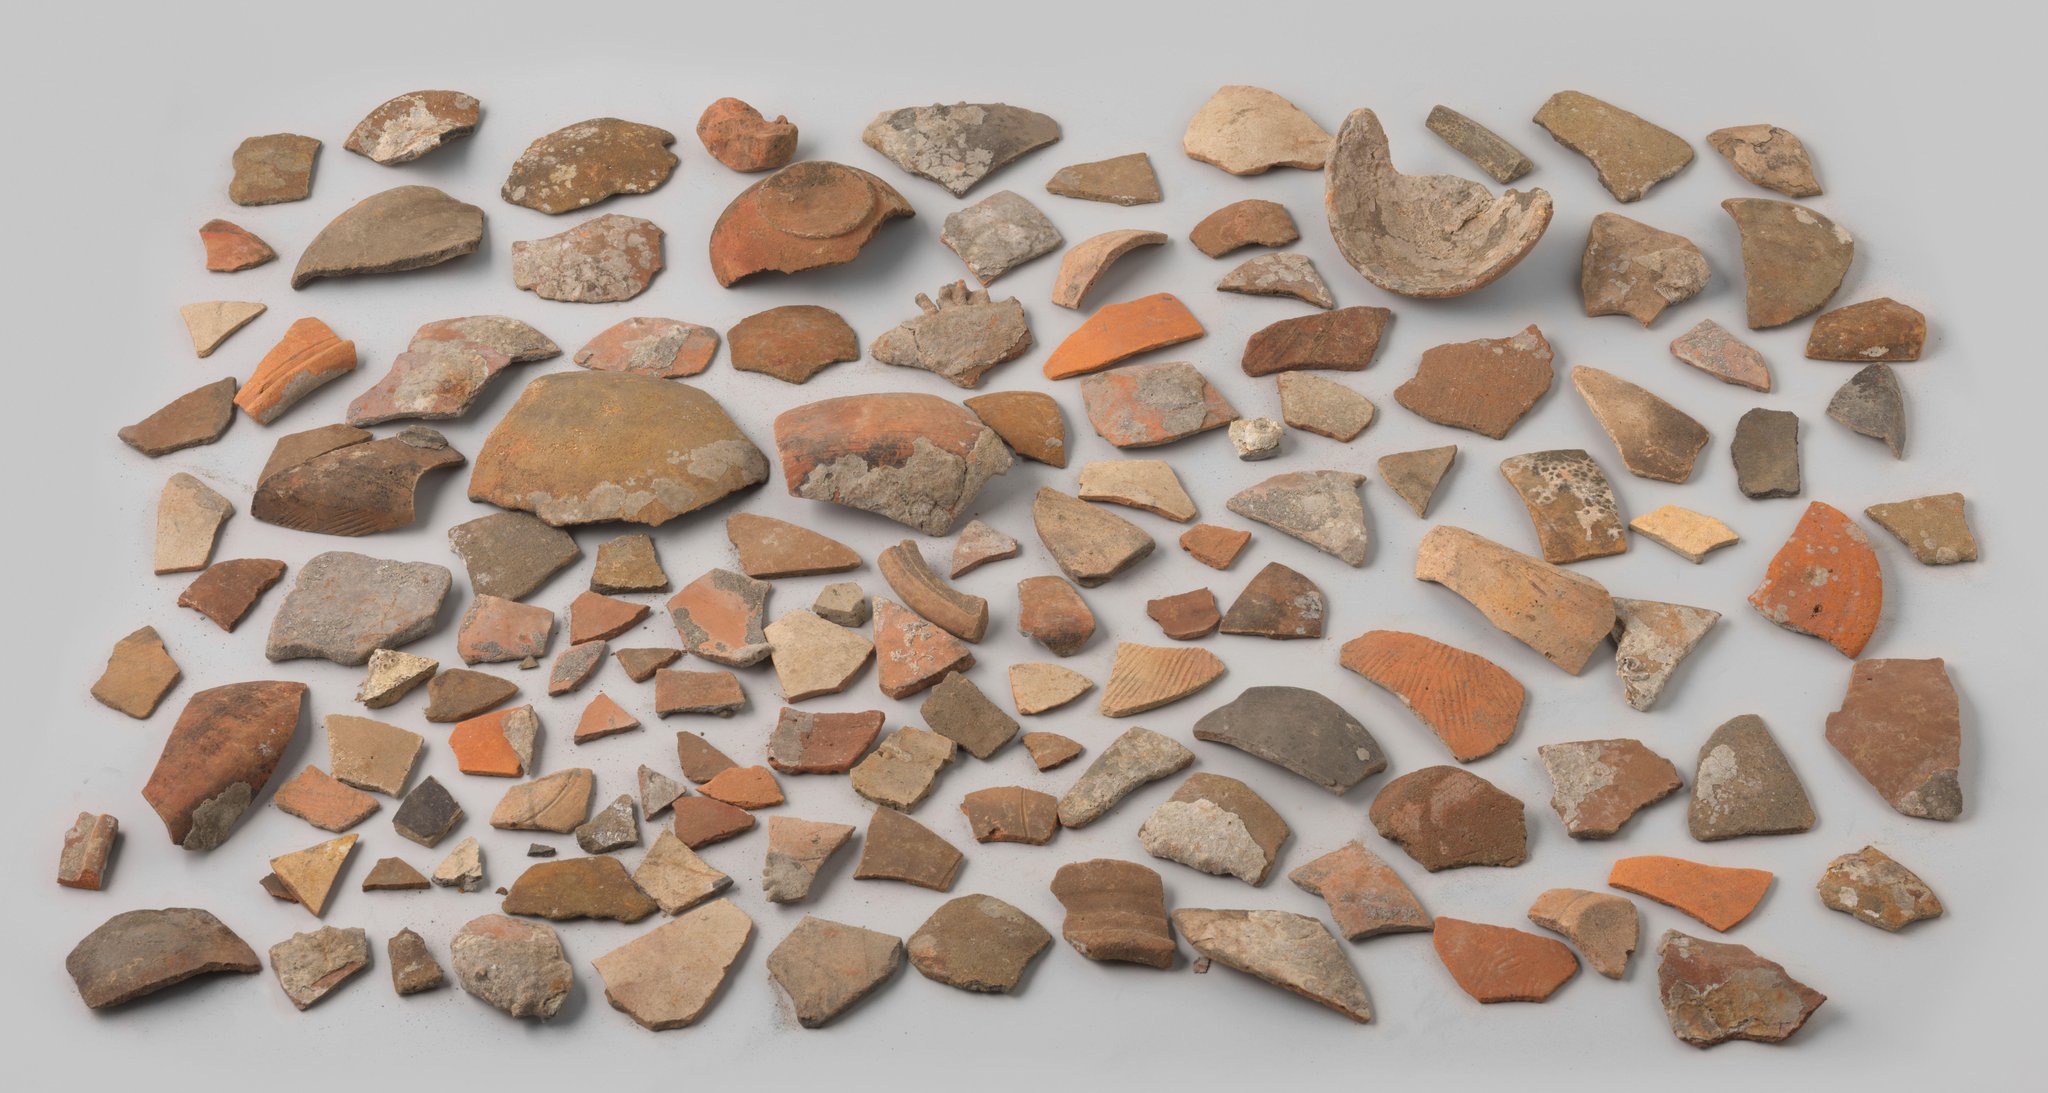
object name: sherd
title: Zak met scherven van aardewerk uit V.O.C.-schip de 'Witte Leeuw'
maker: Anonymous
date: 1613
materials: earthenware, glaze, stoneware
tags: verenigde oostindische compagnie, sint-helena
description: Zak met scherven van roodbakkend, witbakkend en grijsbakkend aardewerk, geglazuurd en ongeglazuurd, en steengoed uit V.O.C.-schip de 'Witte Leeuw'.